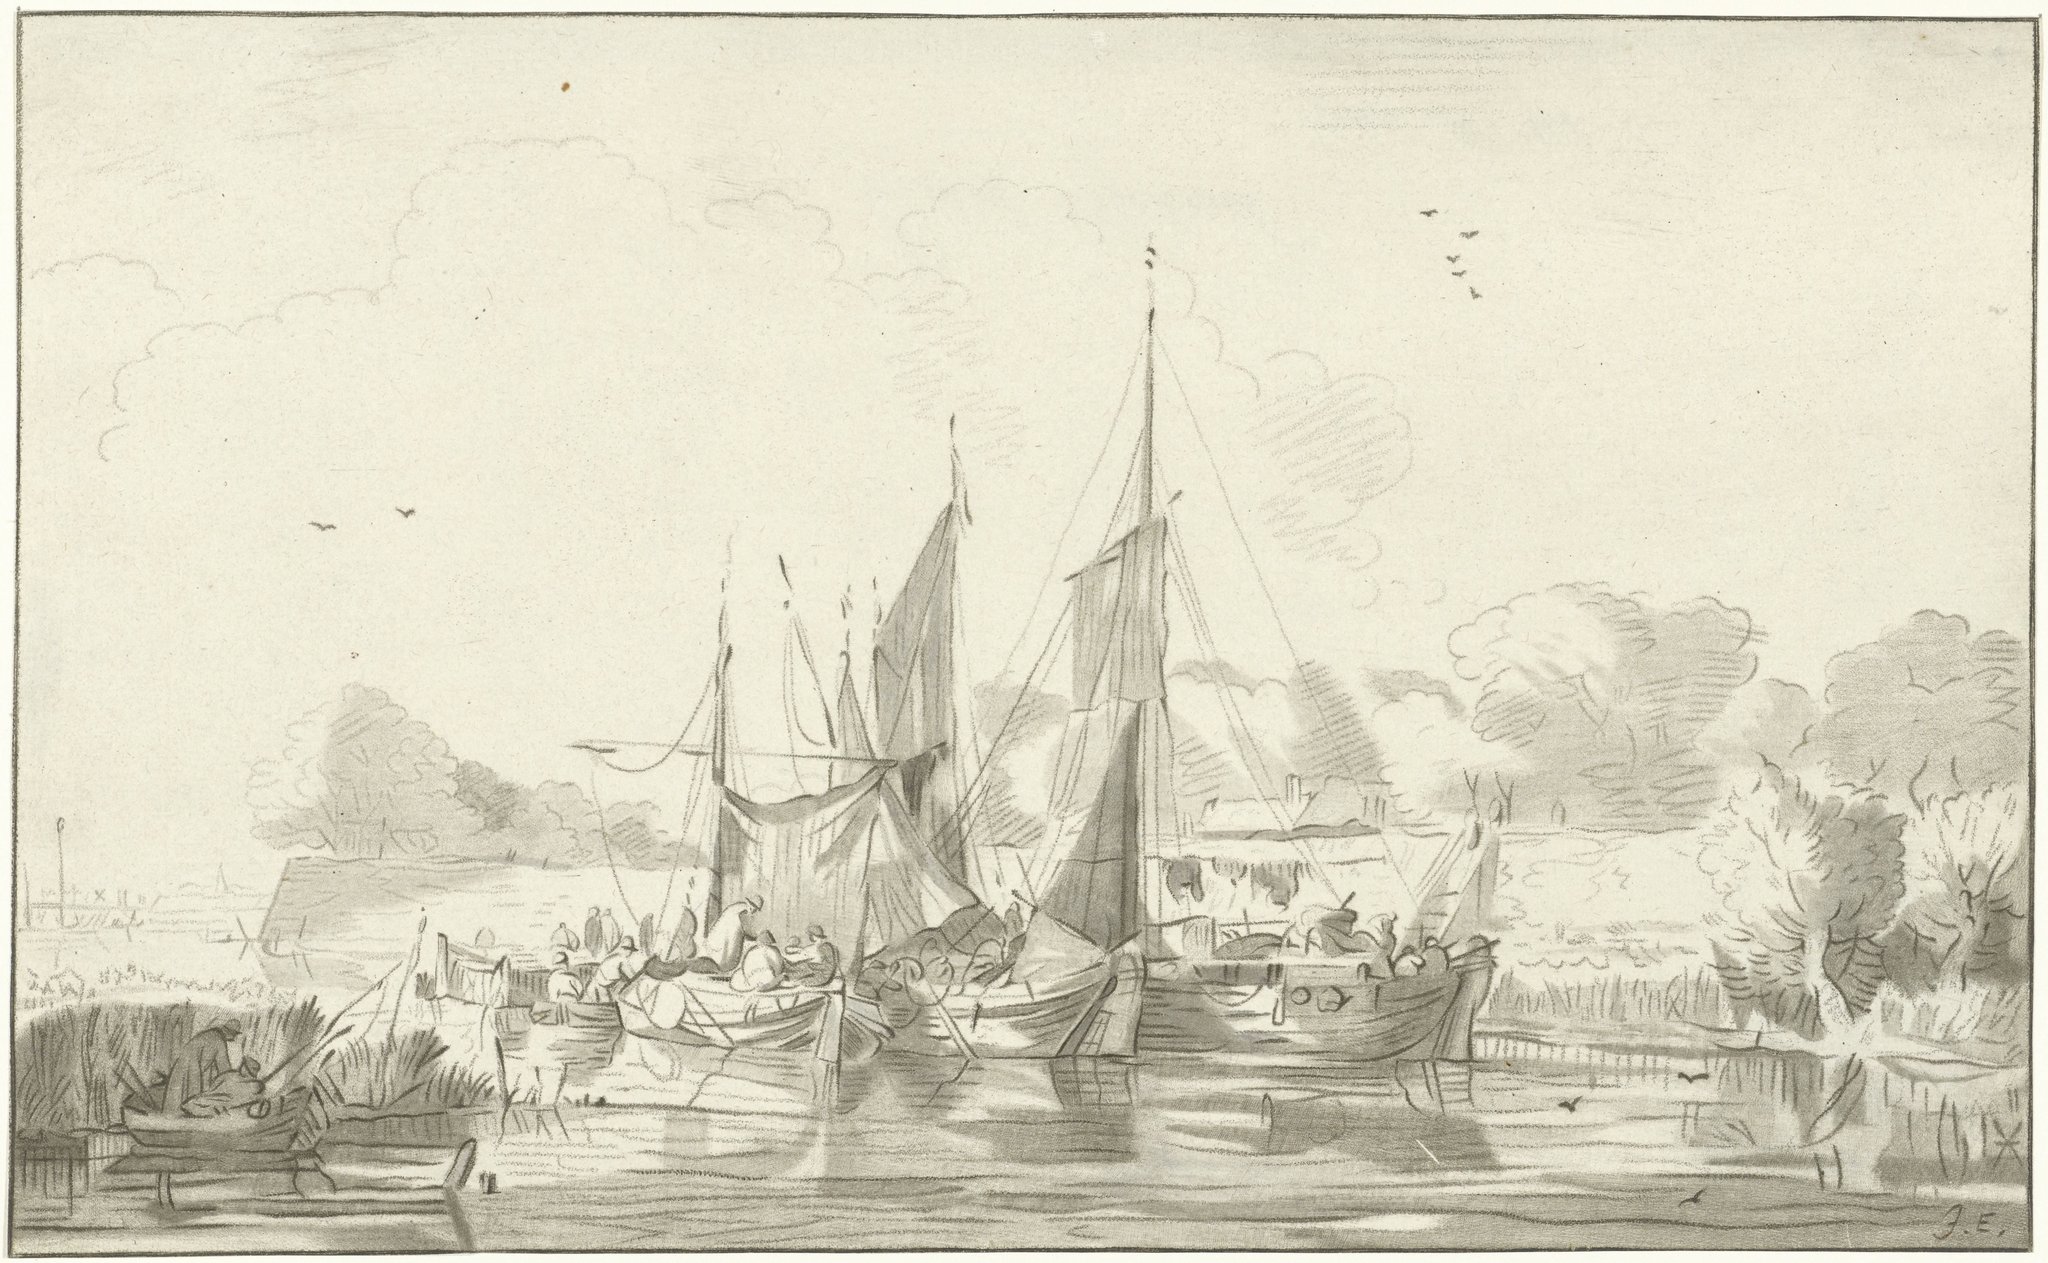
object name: print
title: Riviergezicht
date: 1771-1786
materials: paper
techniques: hand coloring, roulette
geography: amsterdam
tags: sailing-ship, sailing-boat, river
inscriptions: collector's mark: Lugt 2725, collector's mark: Lugt 12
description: Riviergezicht met verschillende zeilschepen en sloepen, die naast elkaar voor anker liggen.